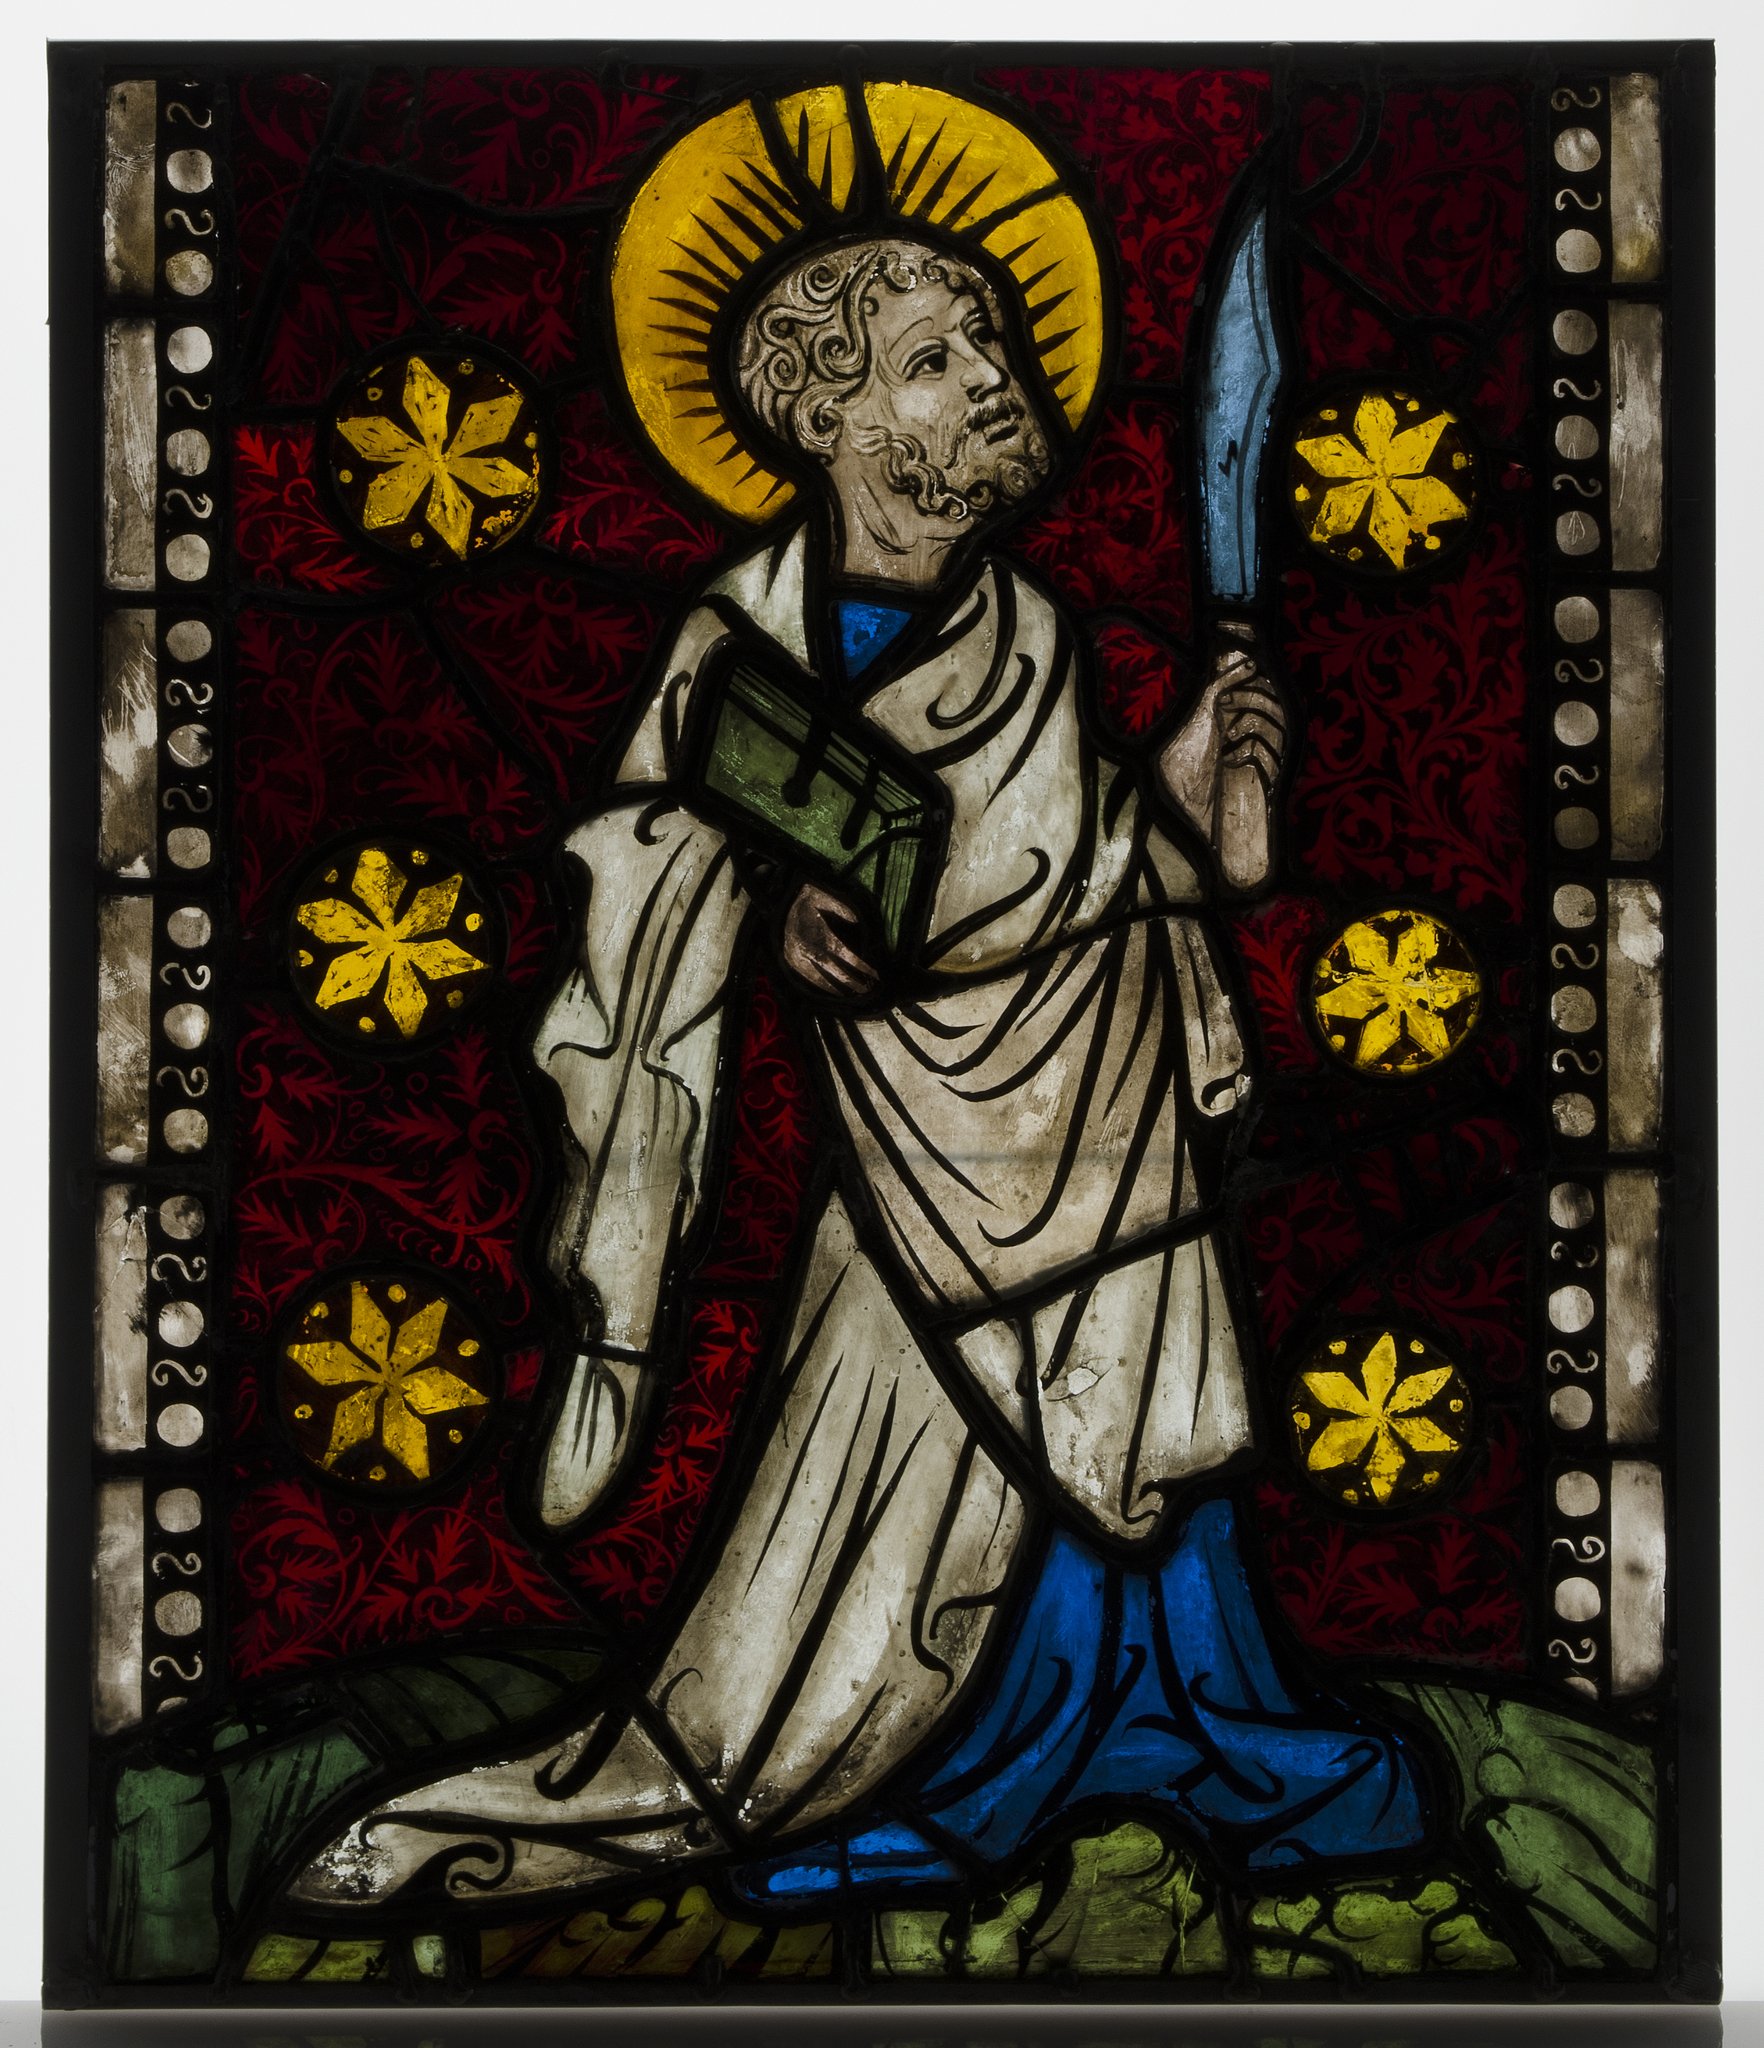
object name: panel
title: Saint Bartholomew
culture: austrian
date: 1410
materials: glass, metal, paint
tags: men,saints